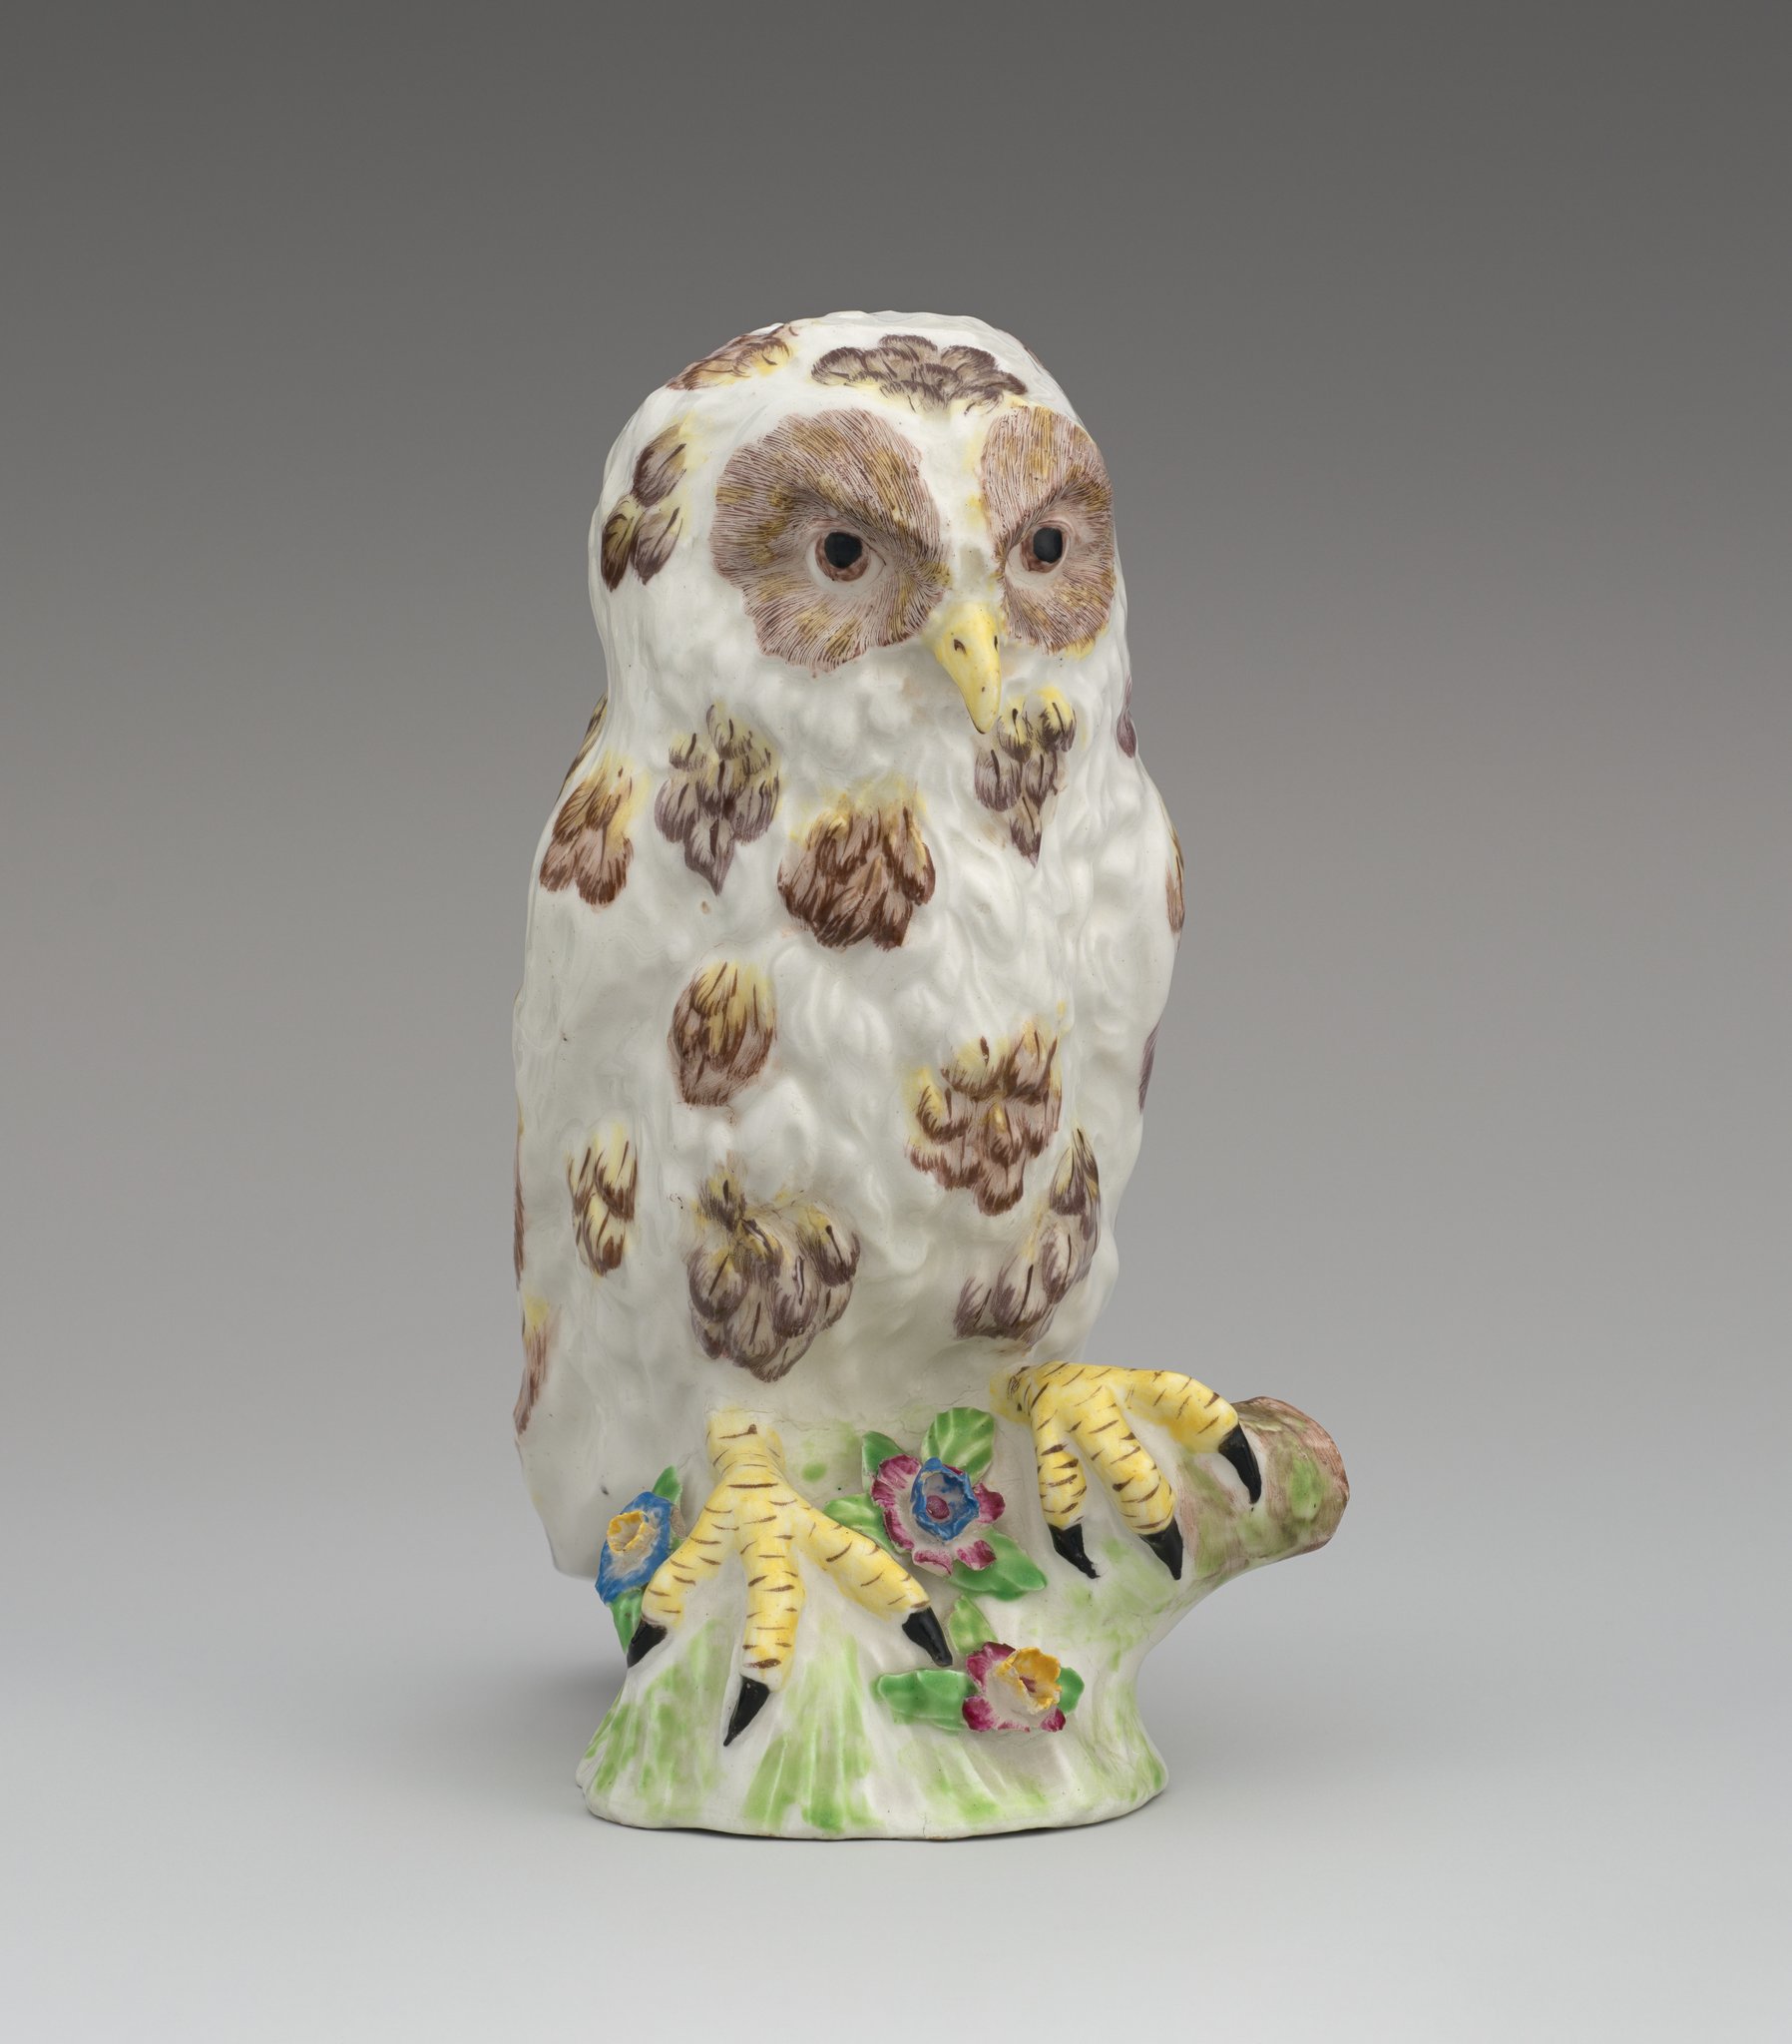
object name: figure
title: Owl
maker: bow porcelain factory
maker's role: factory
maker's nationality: british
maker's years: 1747-1776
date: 1760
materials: soft paste porcelain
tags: owls